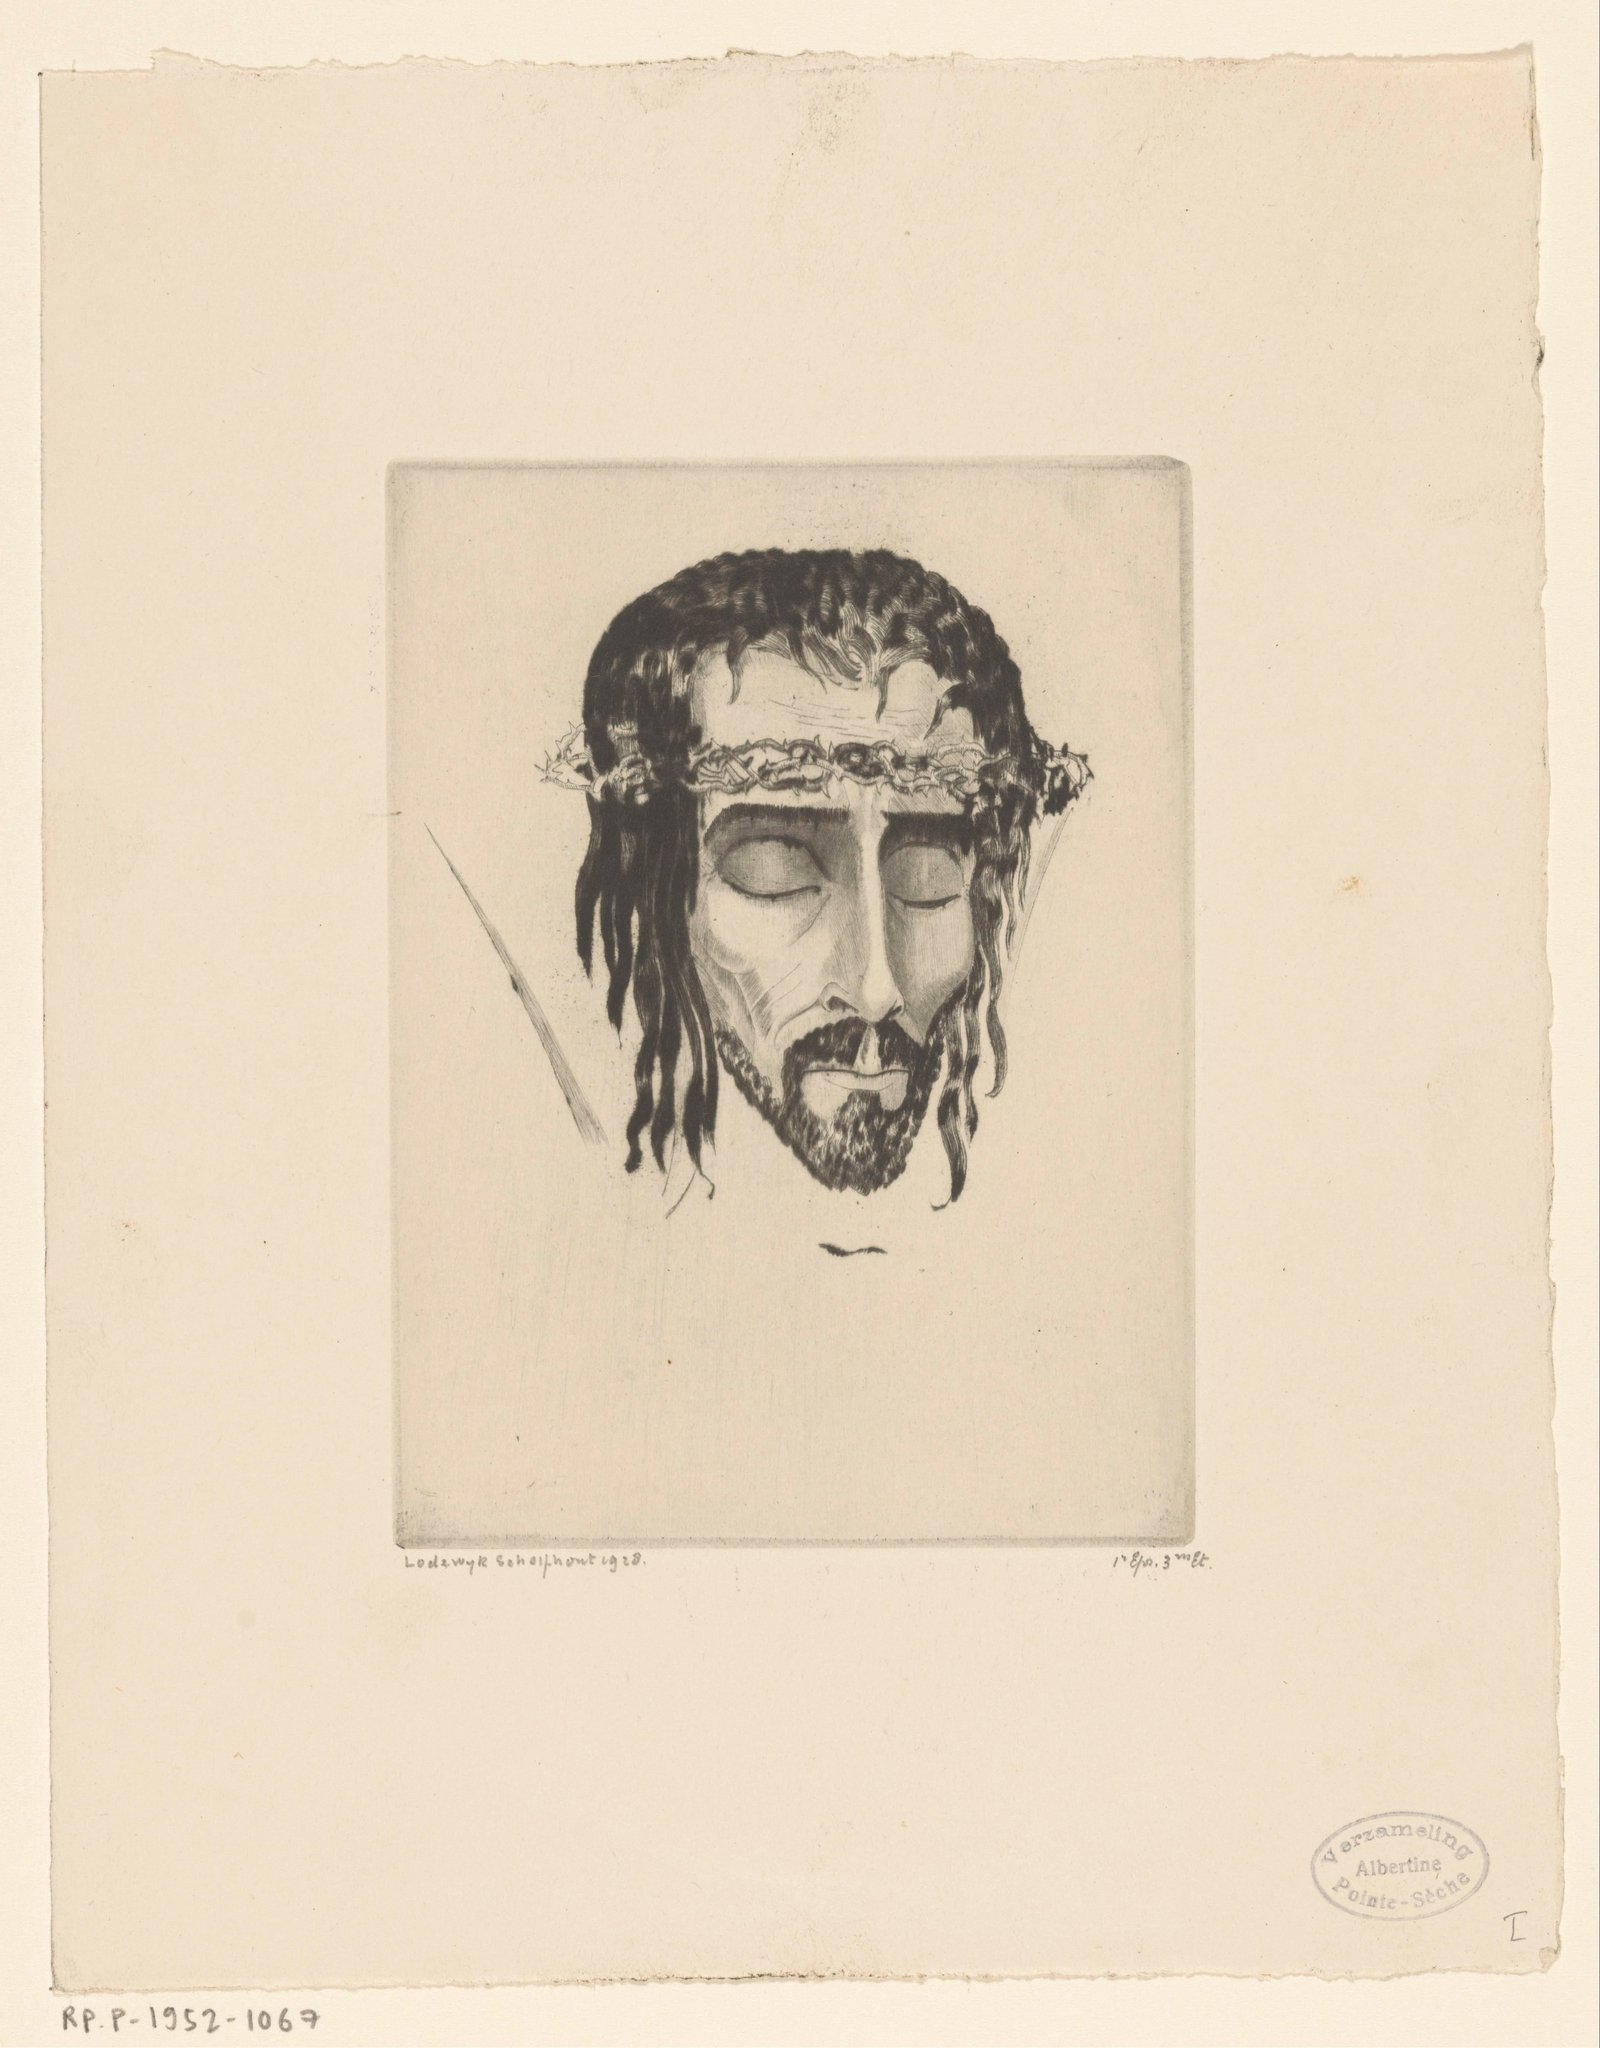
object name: print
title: Hoofd van Christus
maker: lodewijk schelfhout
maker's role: draughtsman, print maker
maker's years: 1881-1943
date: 1928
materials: paper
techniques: drypoint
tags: crown of thorns ~ instruments of the passion, eyes closed, 'portraits' of christ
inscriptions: collector's mark: Lugt 2228, collector's mark: Lugt 5i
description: Christus met doornenkroon en gesloten ogen.